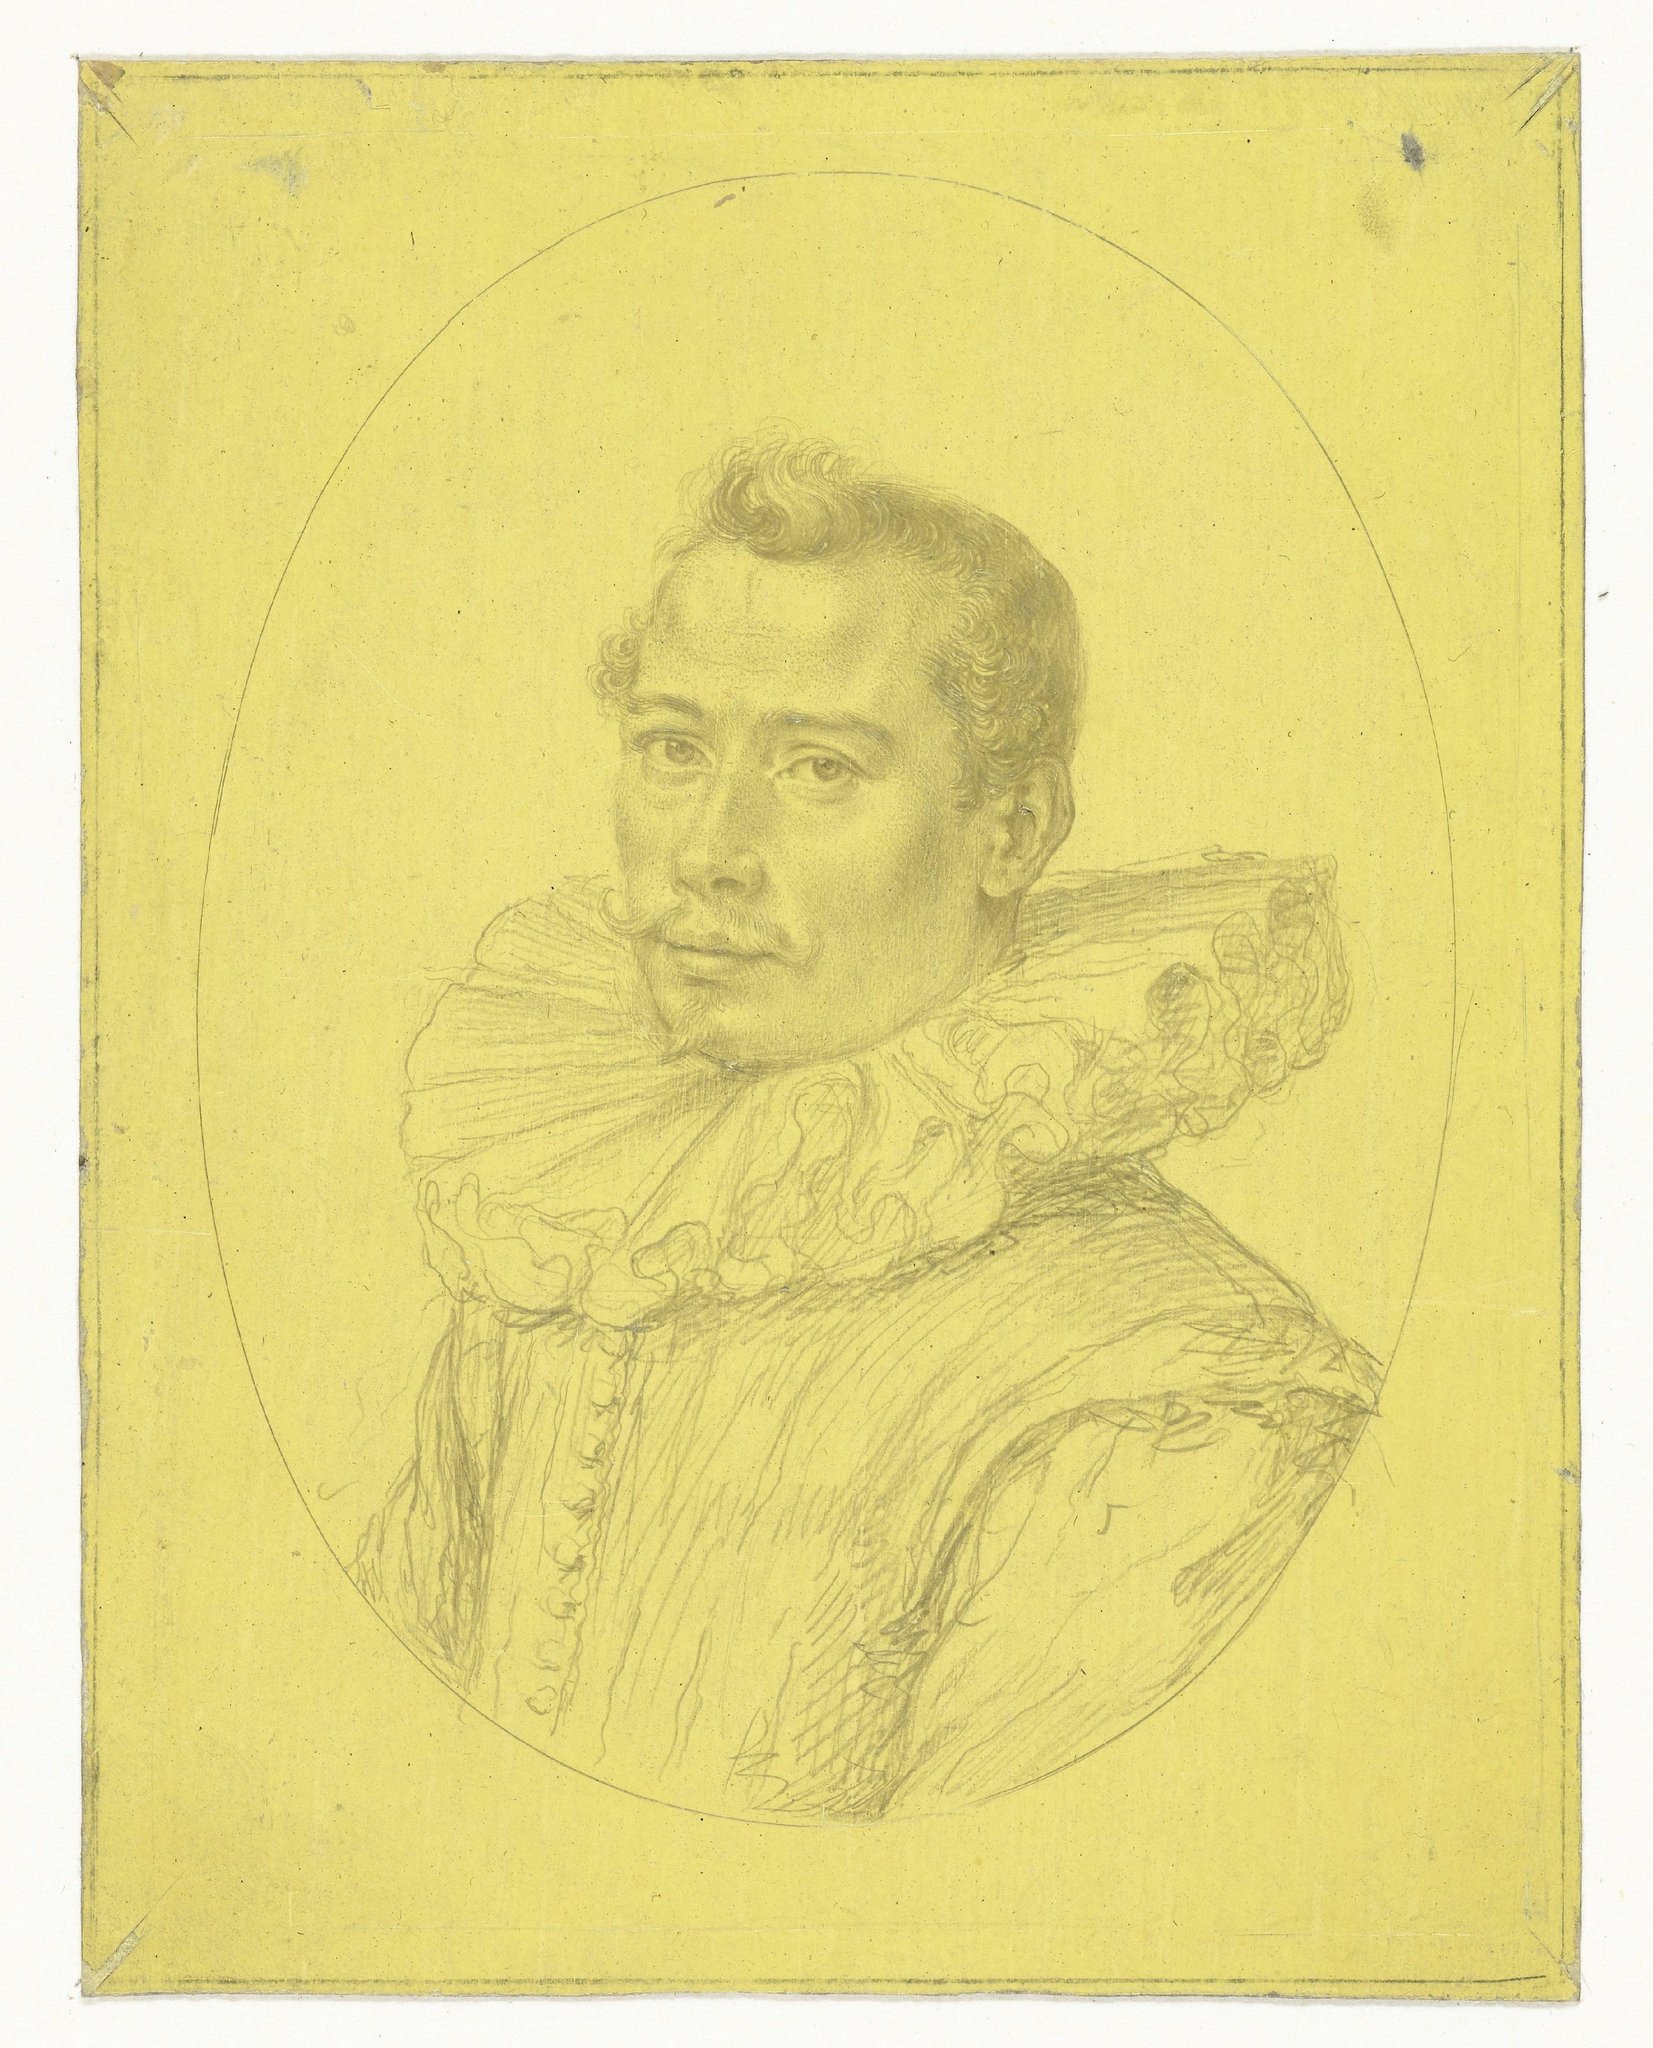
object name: drawing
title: Portret van een onbekende man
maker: jacques de gheyn (ii)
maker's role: painter, print maker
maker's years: 1565-1629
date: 1591-1601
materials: paper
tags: historical persons not known by name